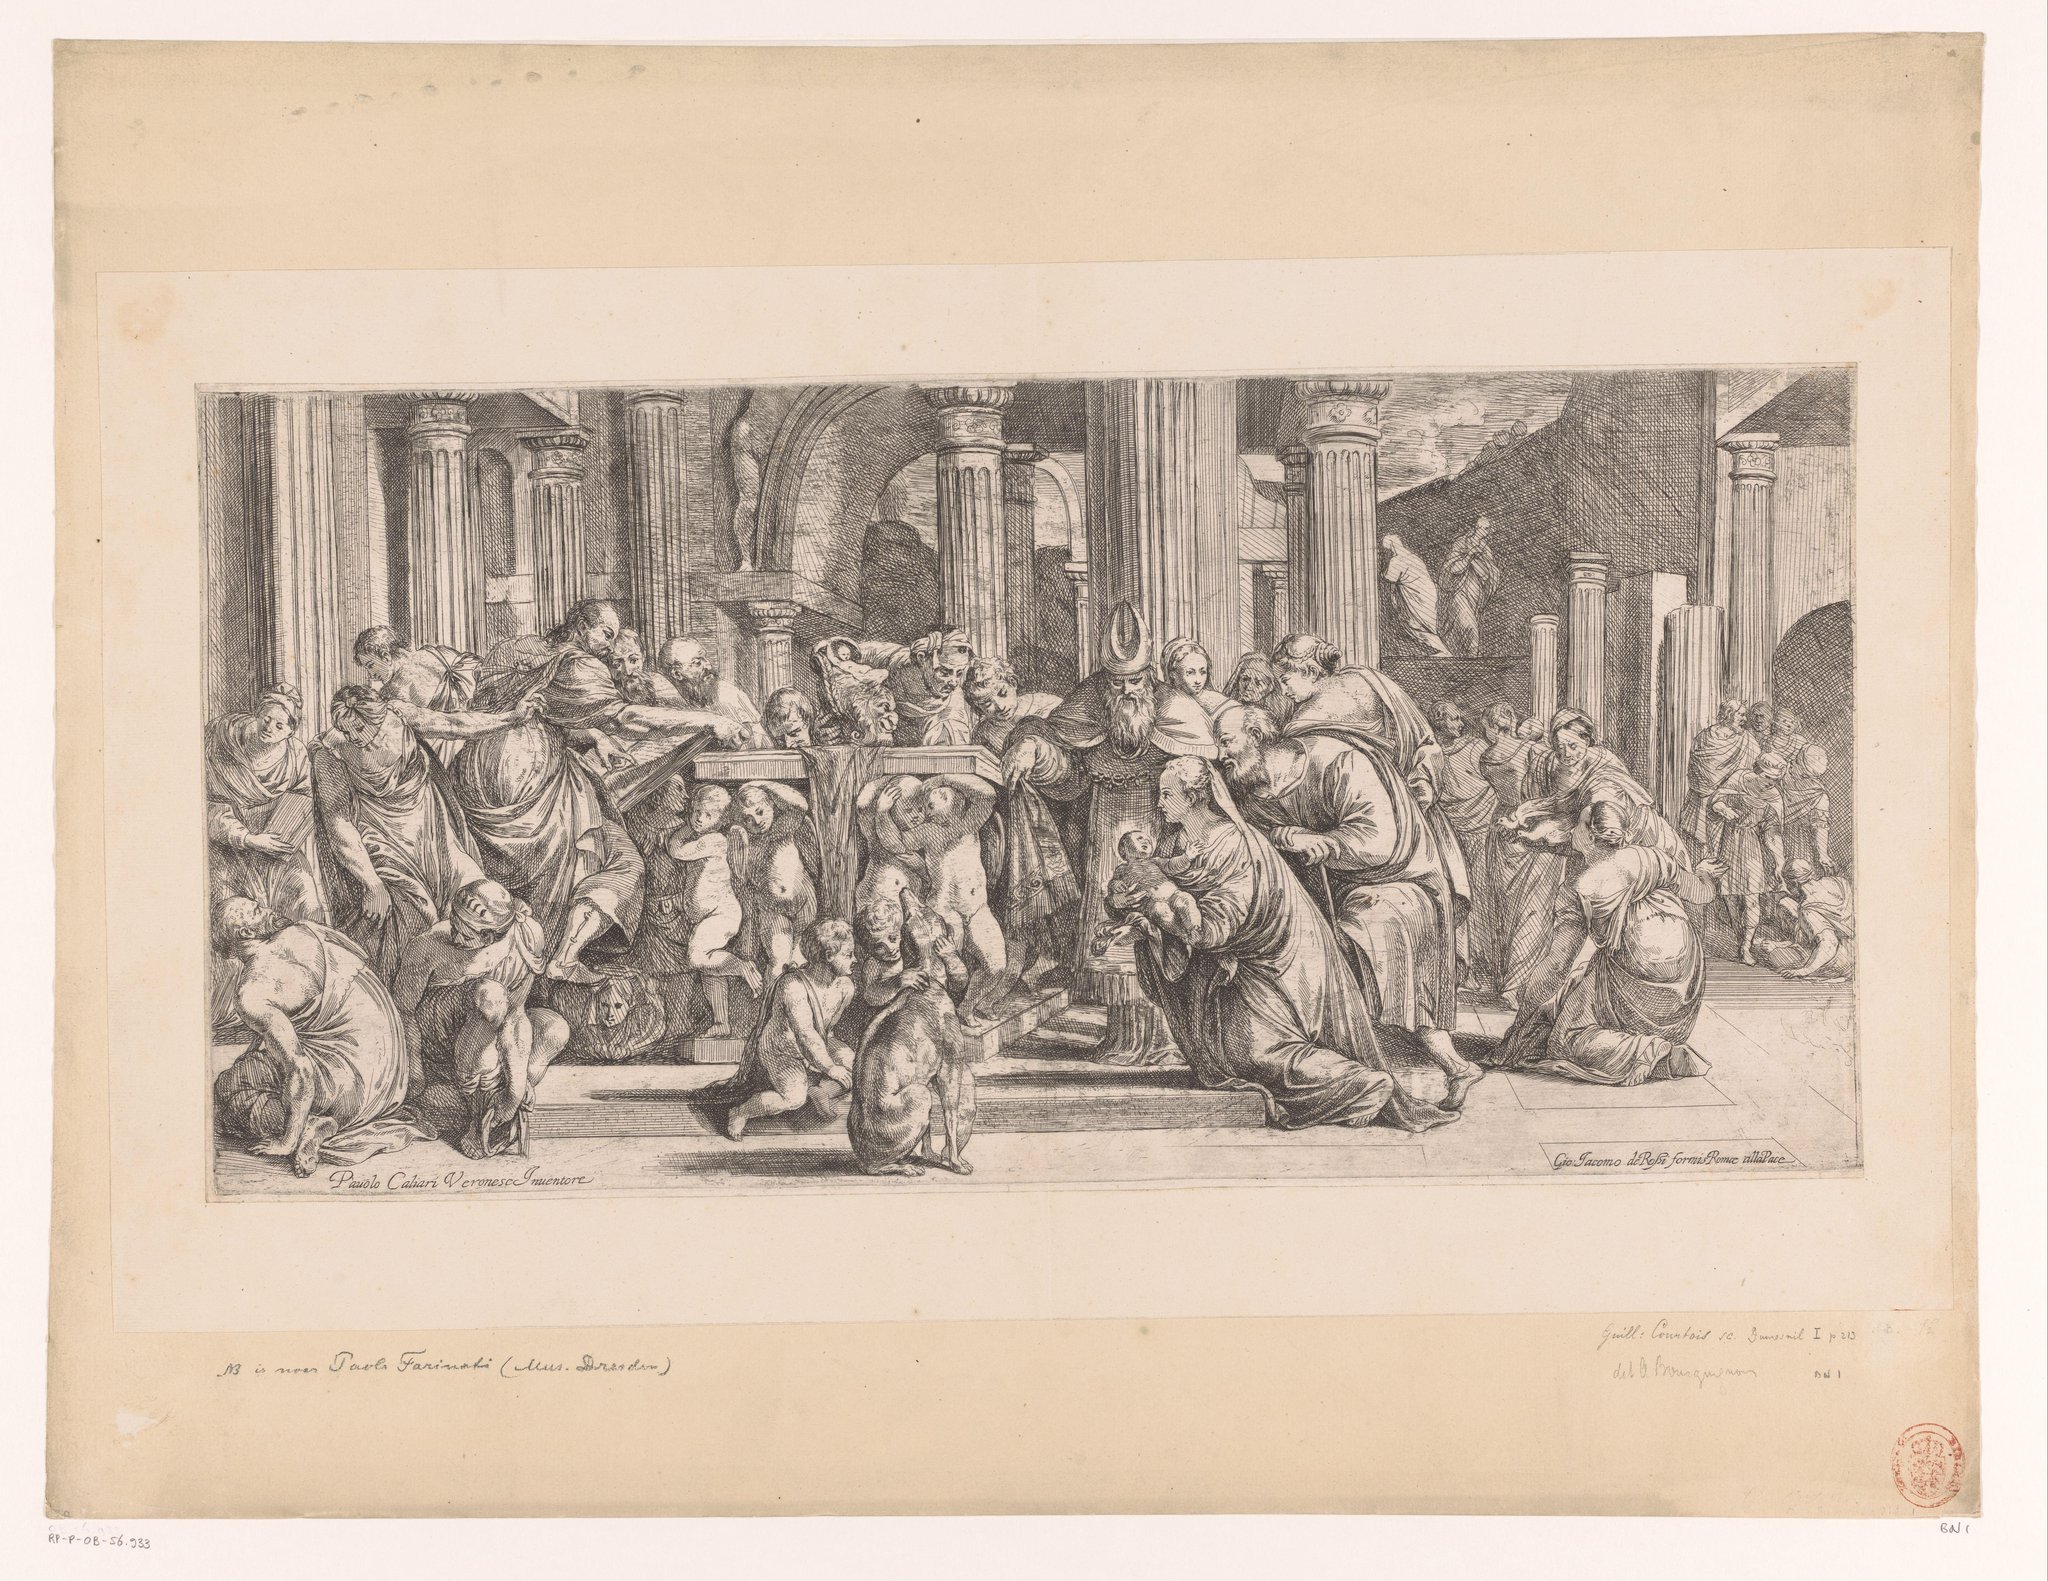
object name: print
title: Presentatie in de tempel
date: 1638-1679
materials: paper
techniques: etching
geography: rome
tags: presentation of the christ-child in the temple, usually simeon (and anna) present (luke 2:22-39)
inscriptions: collector's mark: Lugt 240